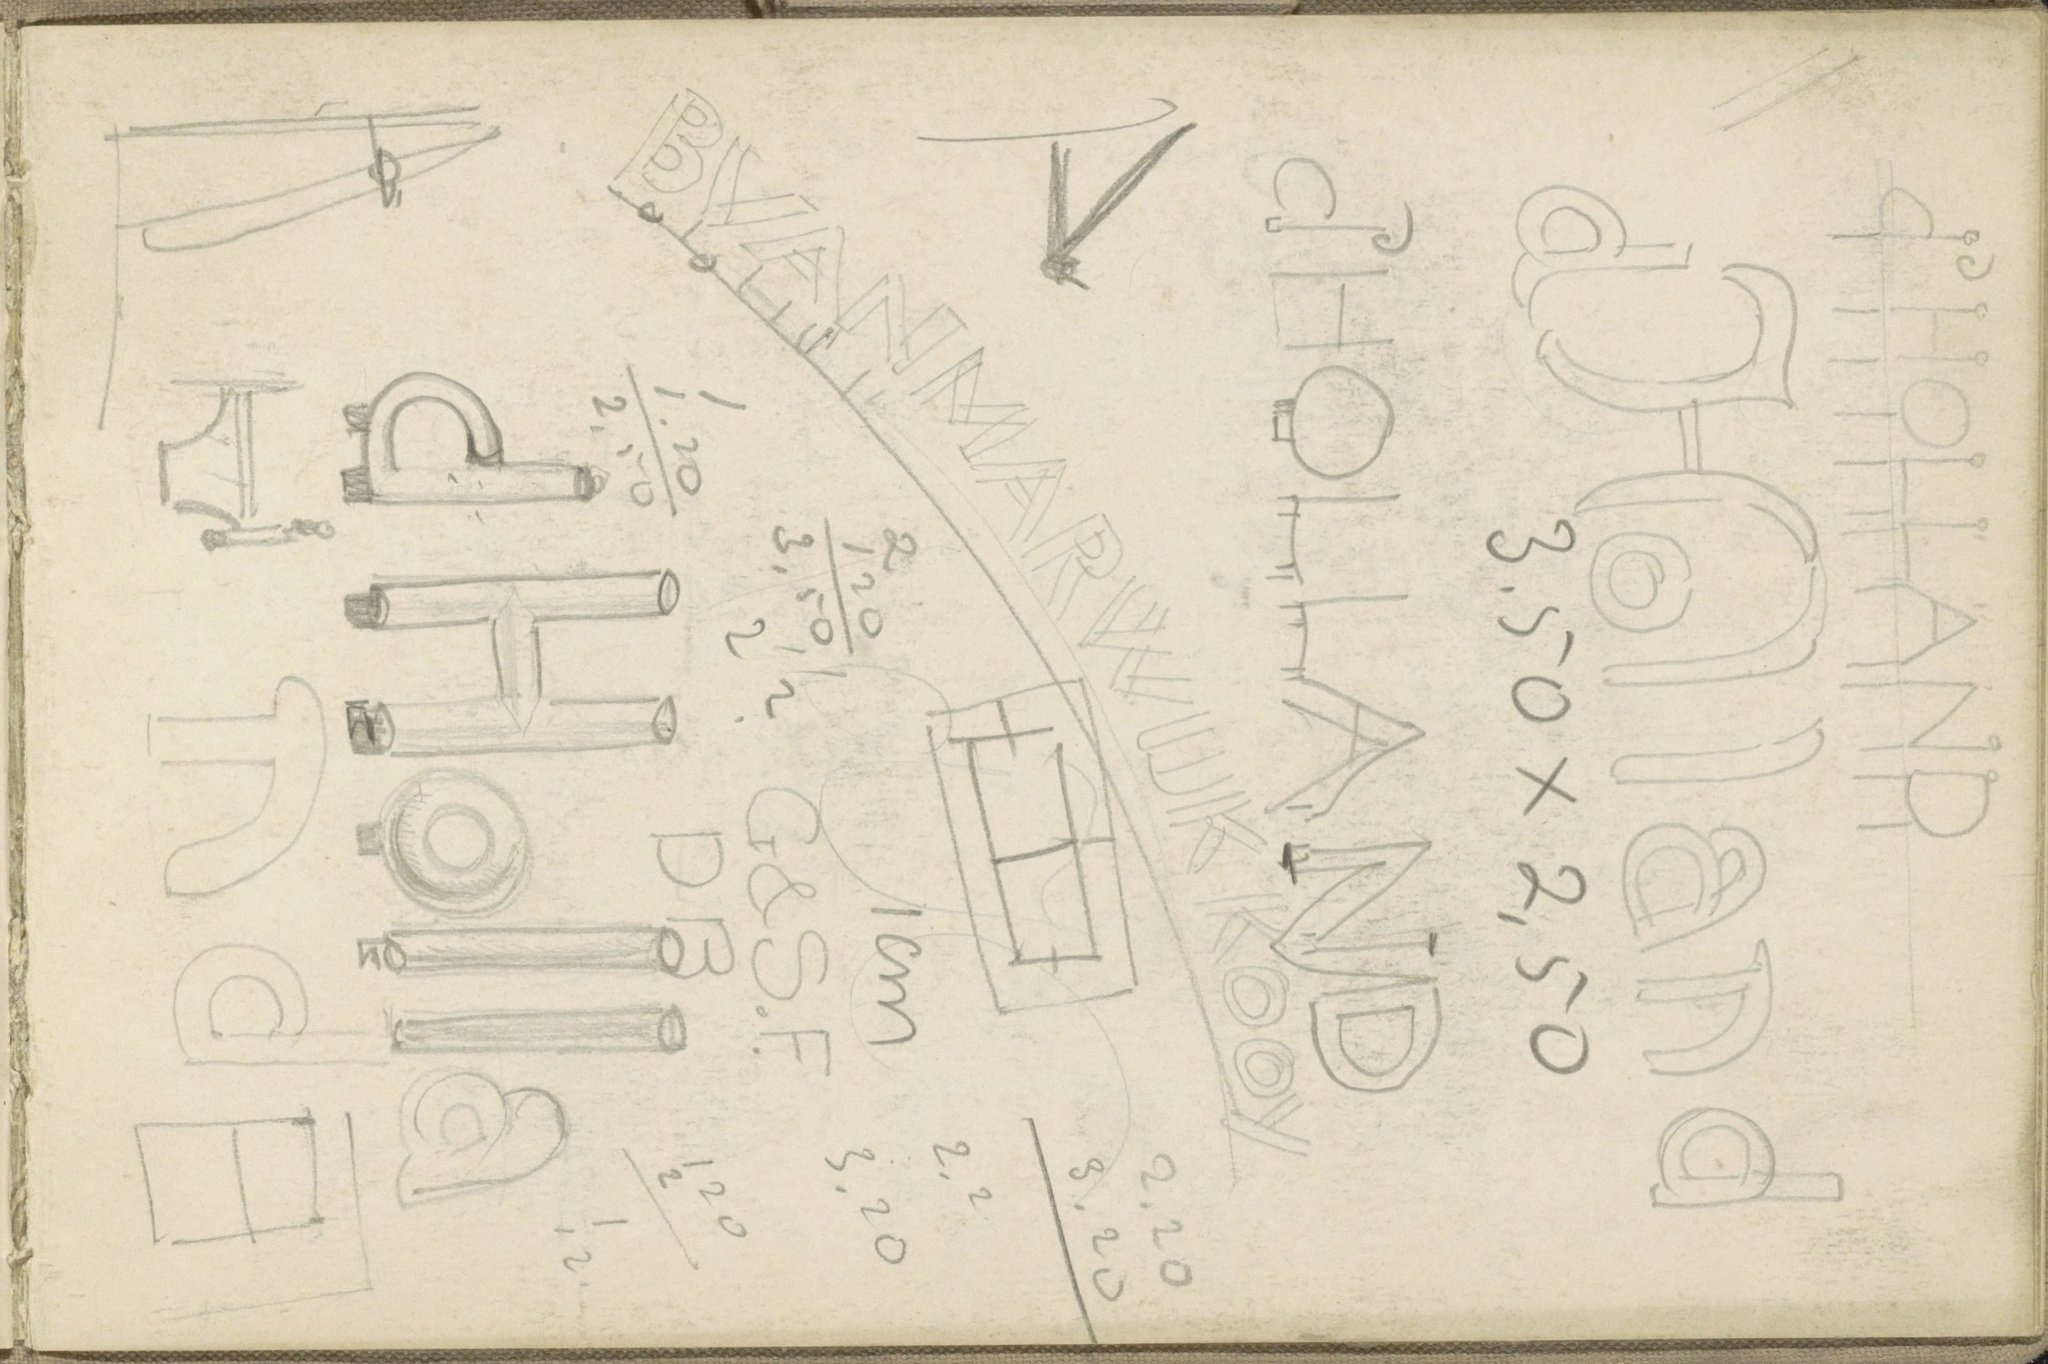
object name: sketchbook leaf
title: Typografische ontwerpen voor Stoommeelfabriek Holland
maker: carel adolph lion cachet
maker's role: draughtsman, print maker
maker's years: 1864-1945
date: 1905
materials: paper, pencil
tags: fancy letters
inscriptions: annotation: ‘d'Holland’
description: Blad 23 recto uit een schetsboek met 27 bladen.